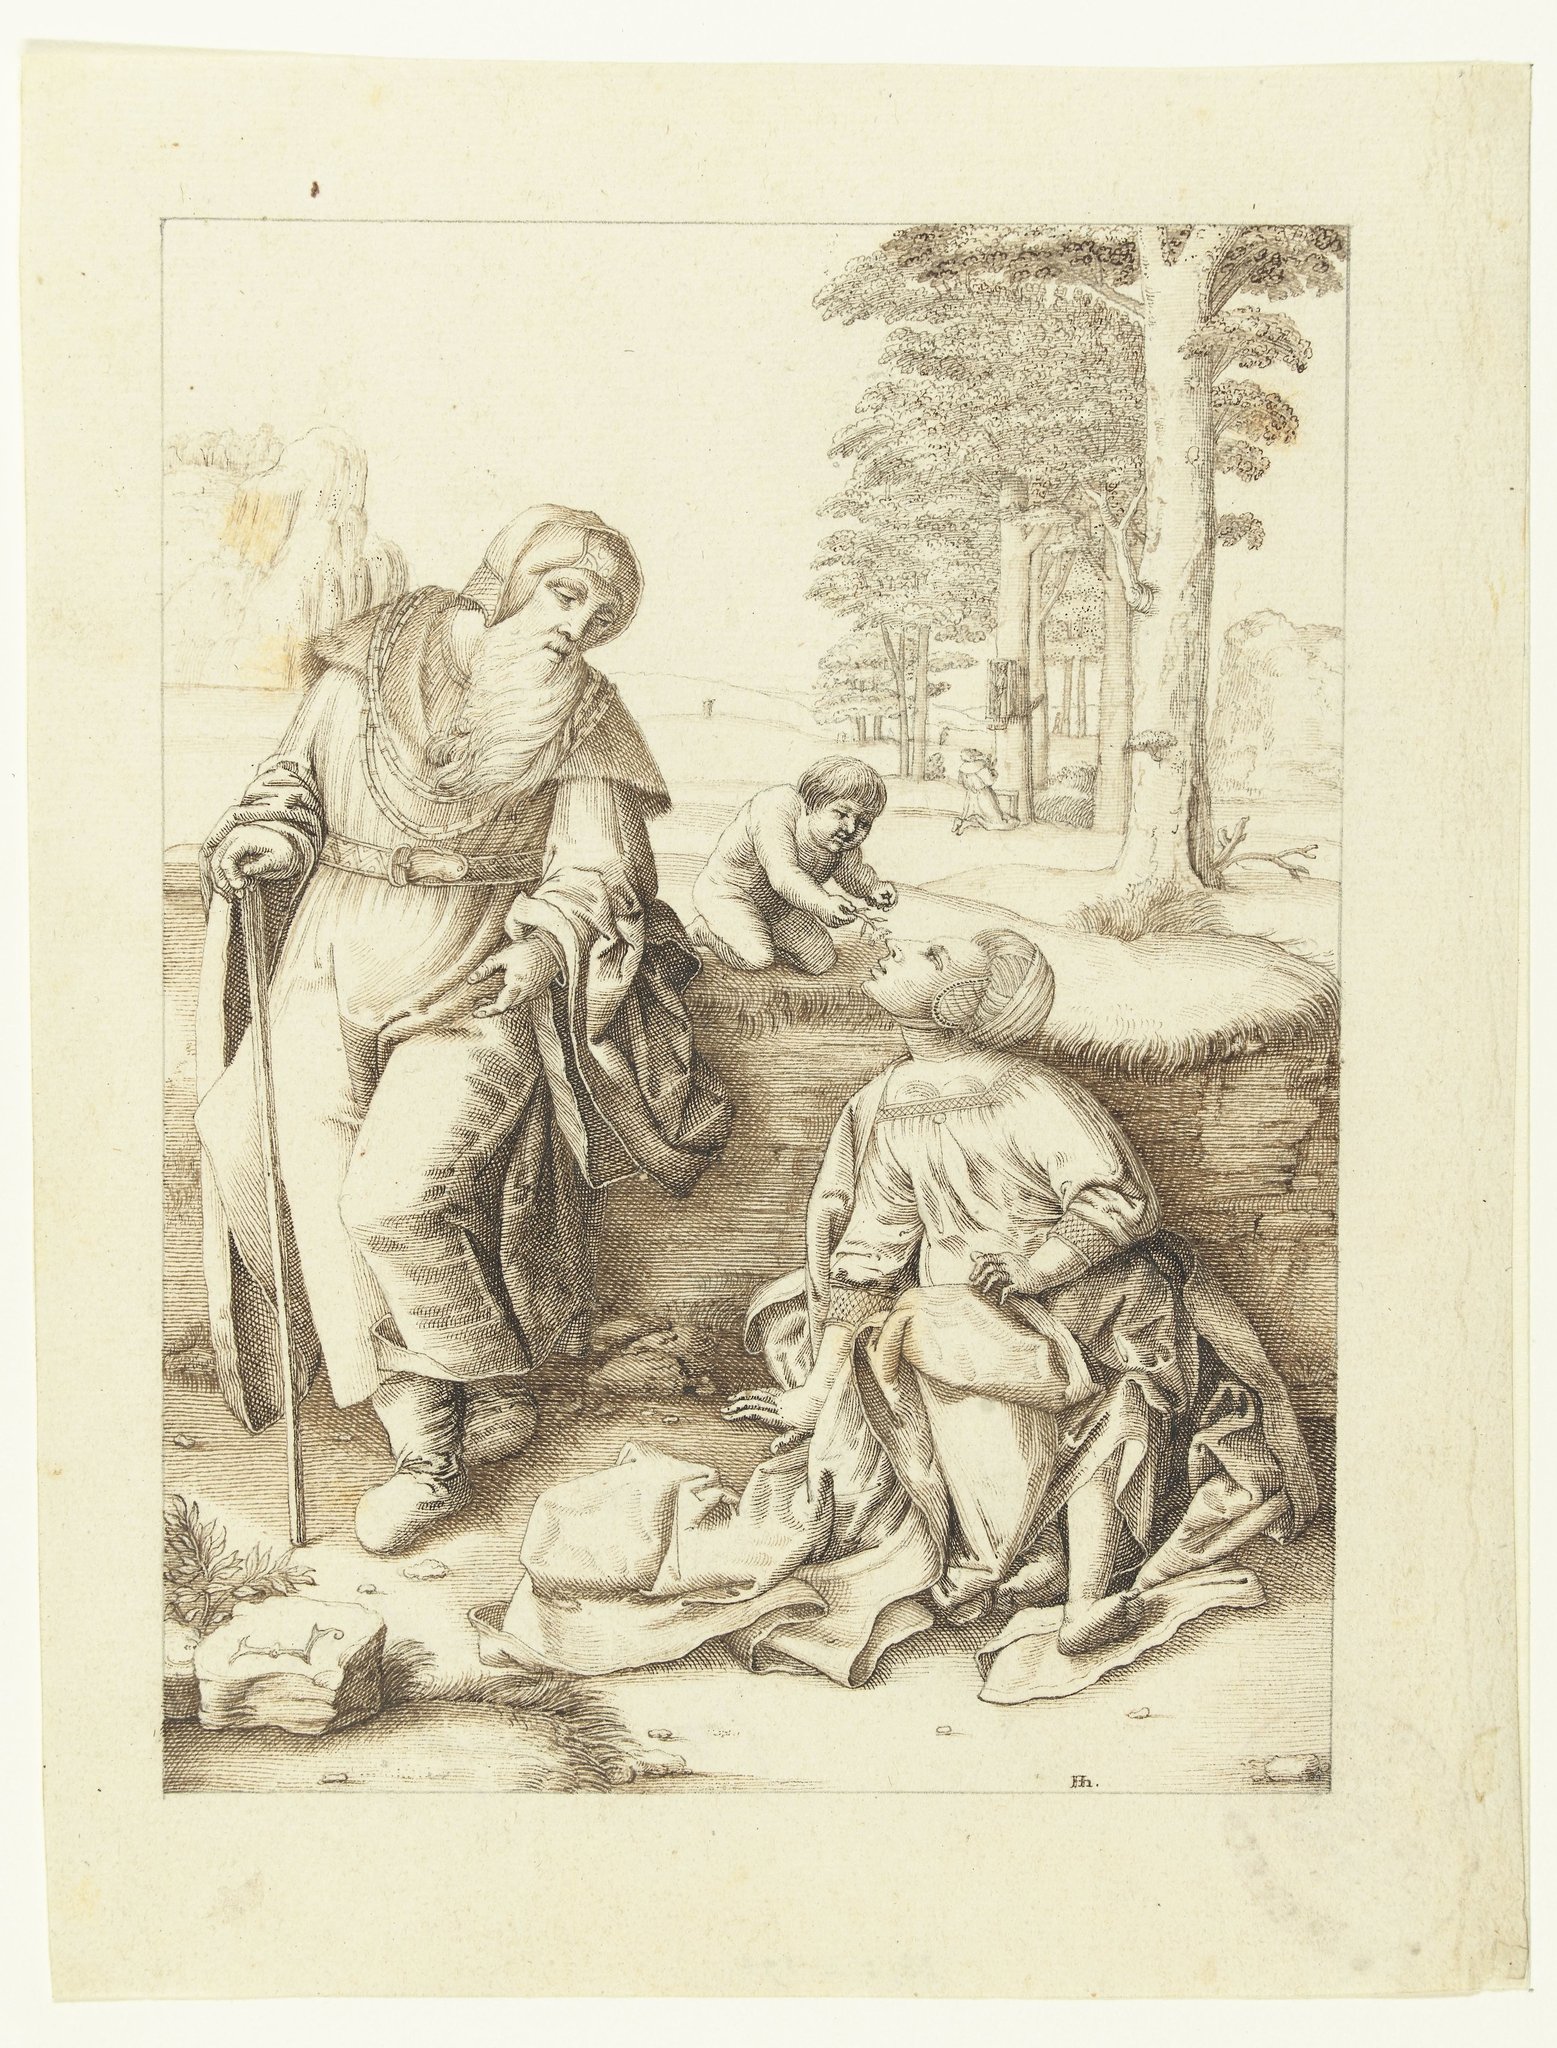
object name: drawing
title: De heilige familie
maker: hendrick hondius (i)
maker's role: draughtsman, print maker, publisher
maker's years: 1573-1650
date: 1583-1650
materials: paper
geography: low countries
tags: holy family, and derived representations, pilgrim(s)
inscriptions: collector's mark: Lugt 240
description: Getekende kopie naar een prent. Heilige familie gekleed als pelgrims.